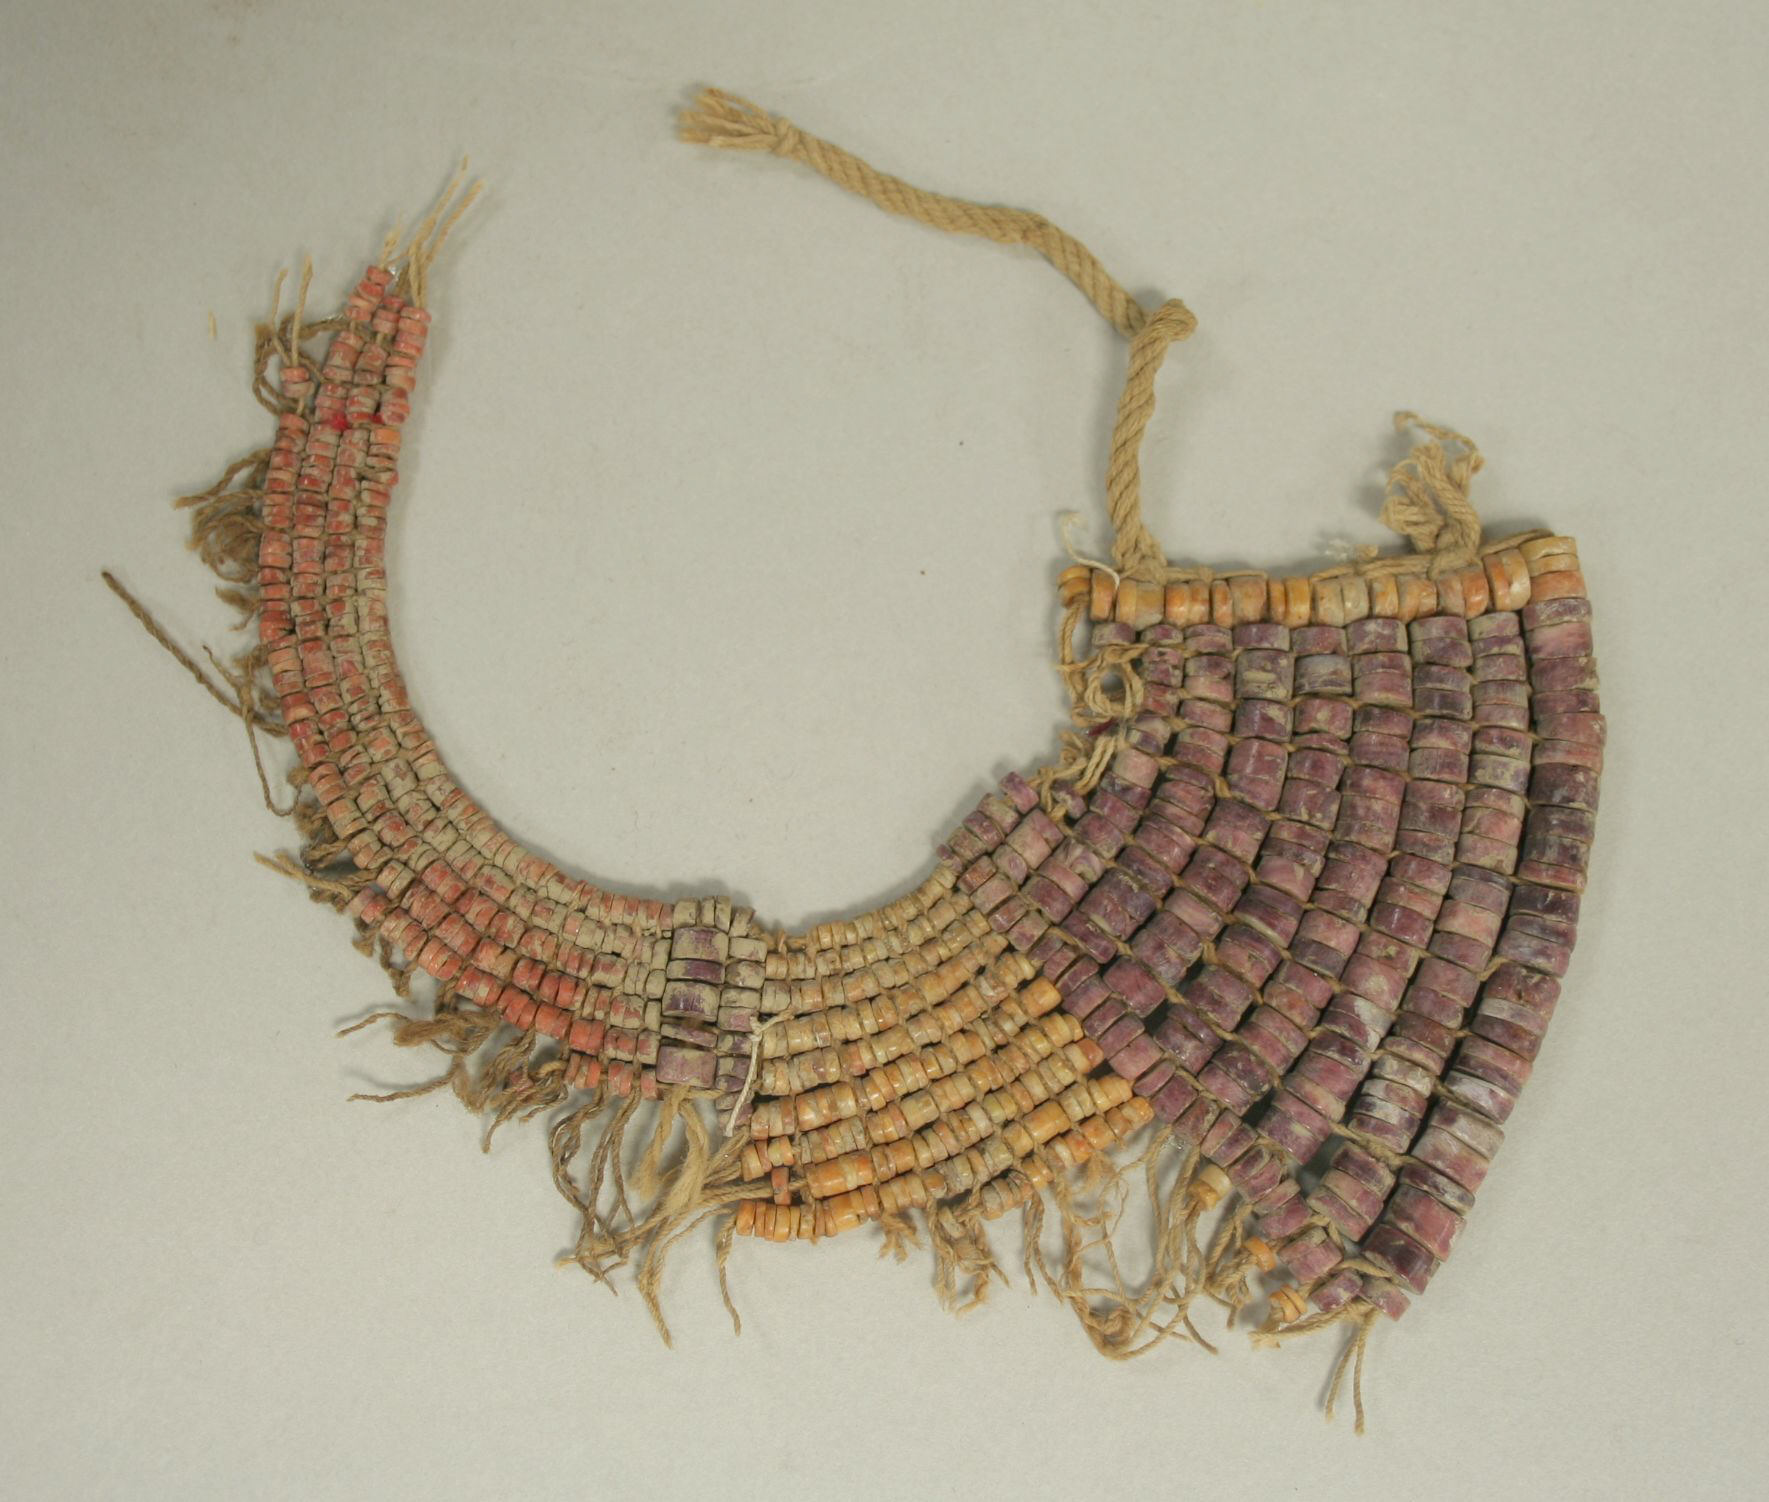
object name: collar fragment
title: Collar of Shell Beads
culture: chancay or chimú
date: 1400-1450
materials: shell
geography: peru